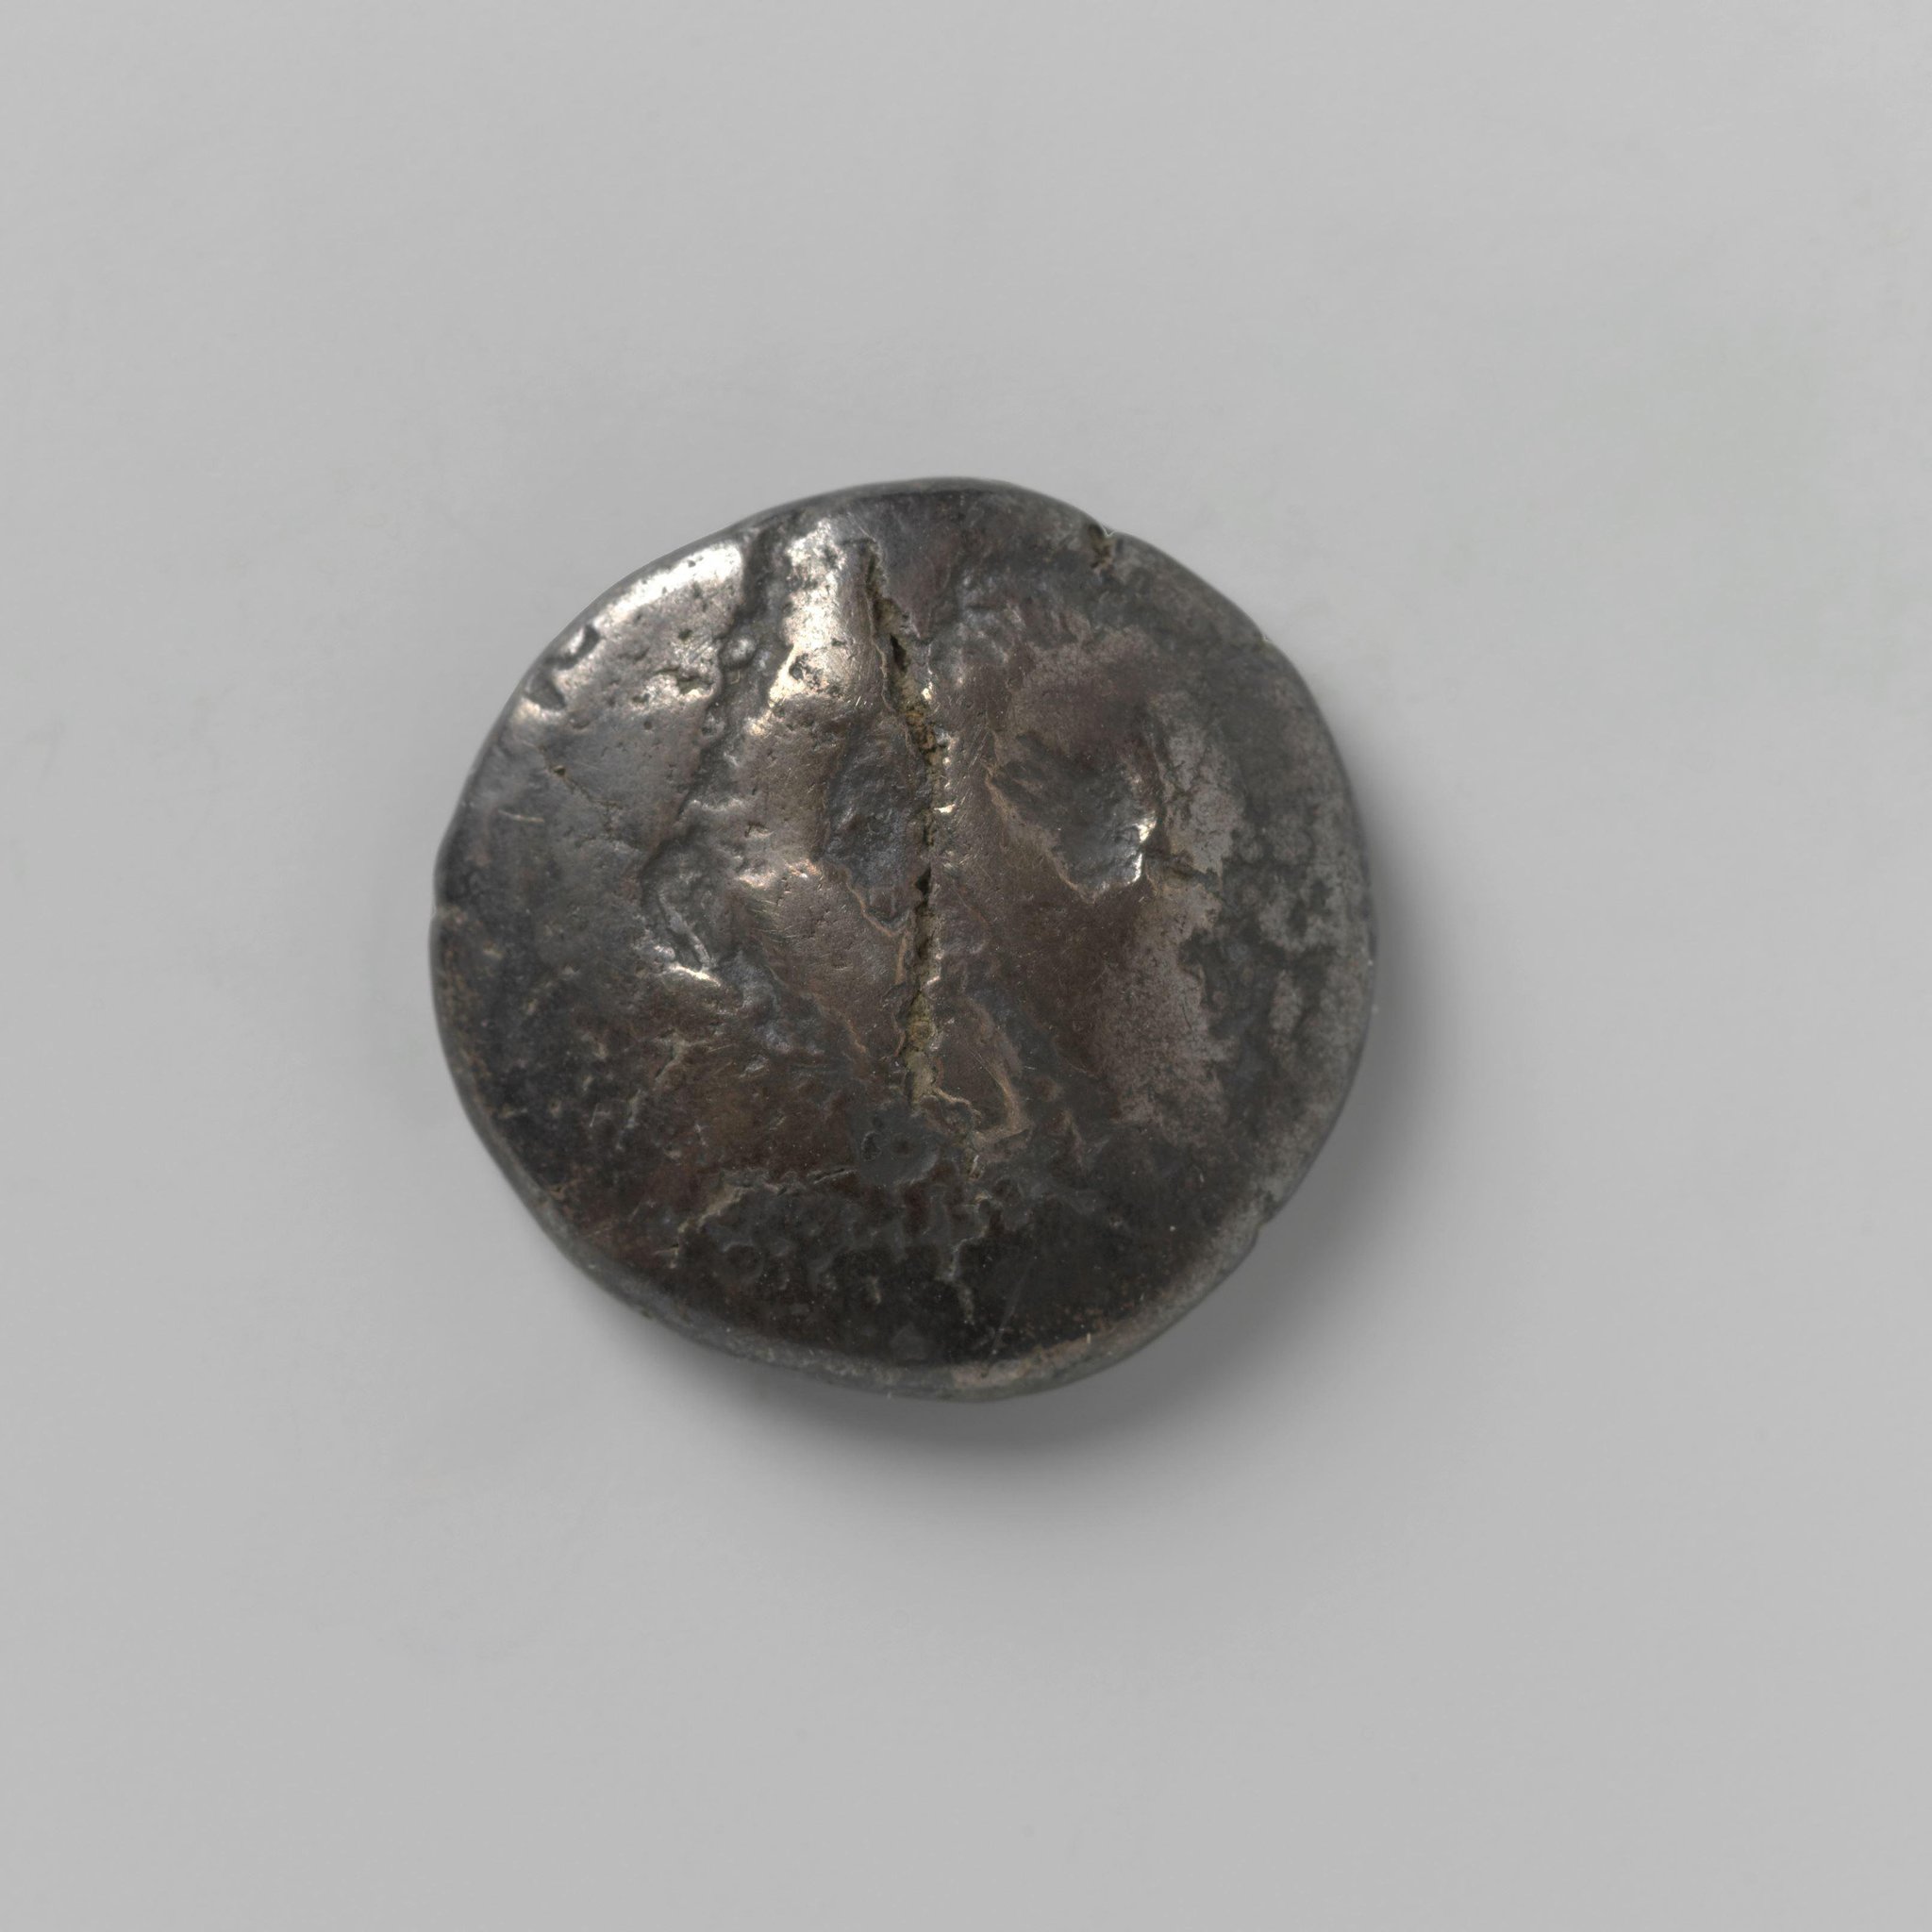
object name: coin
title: Java, koninkrijk Majopahit, djampel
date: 1290-1520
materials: silver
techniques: striking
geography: java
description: Zilveren schotelvormige munt. Voorzijde: letterteken in devanagari-schrift [maa?]. Keerzijde, figuratie [bloem?].